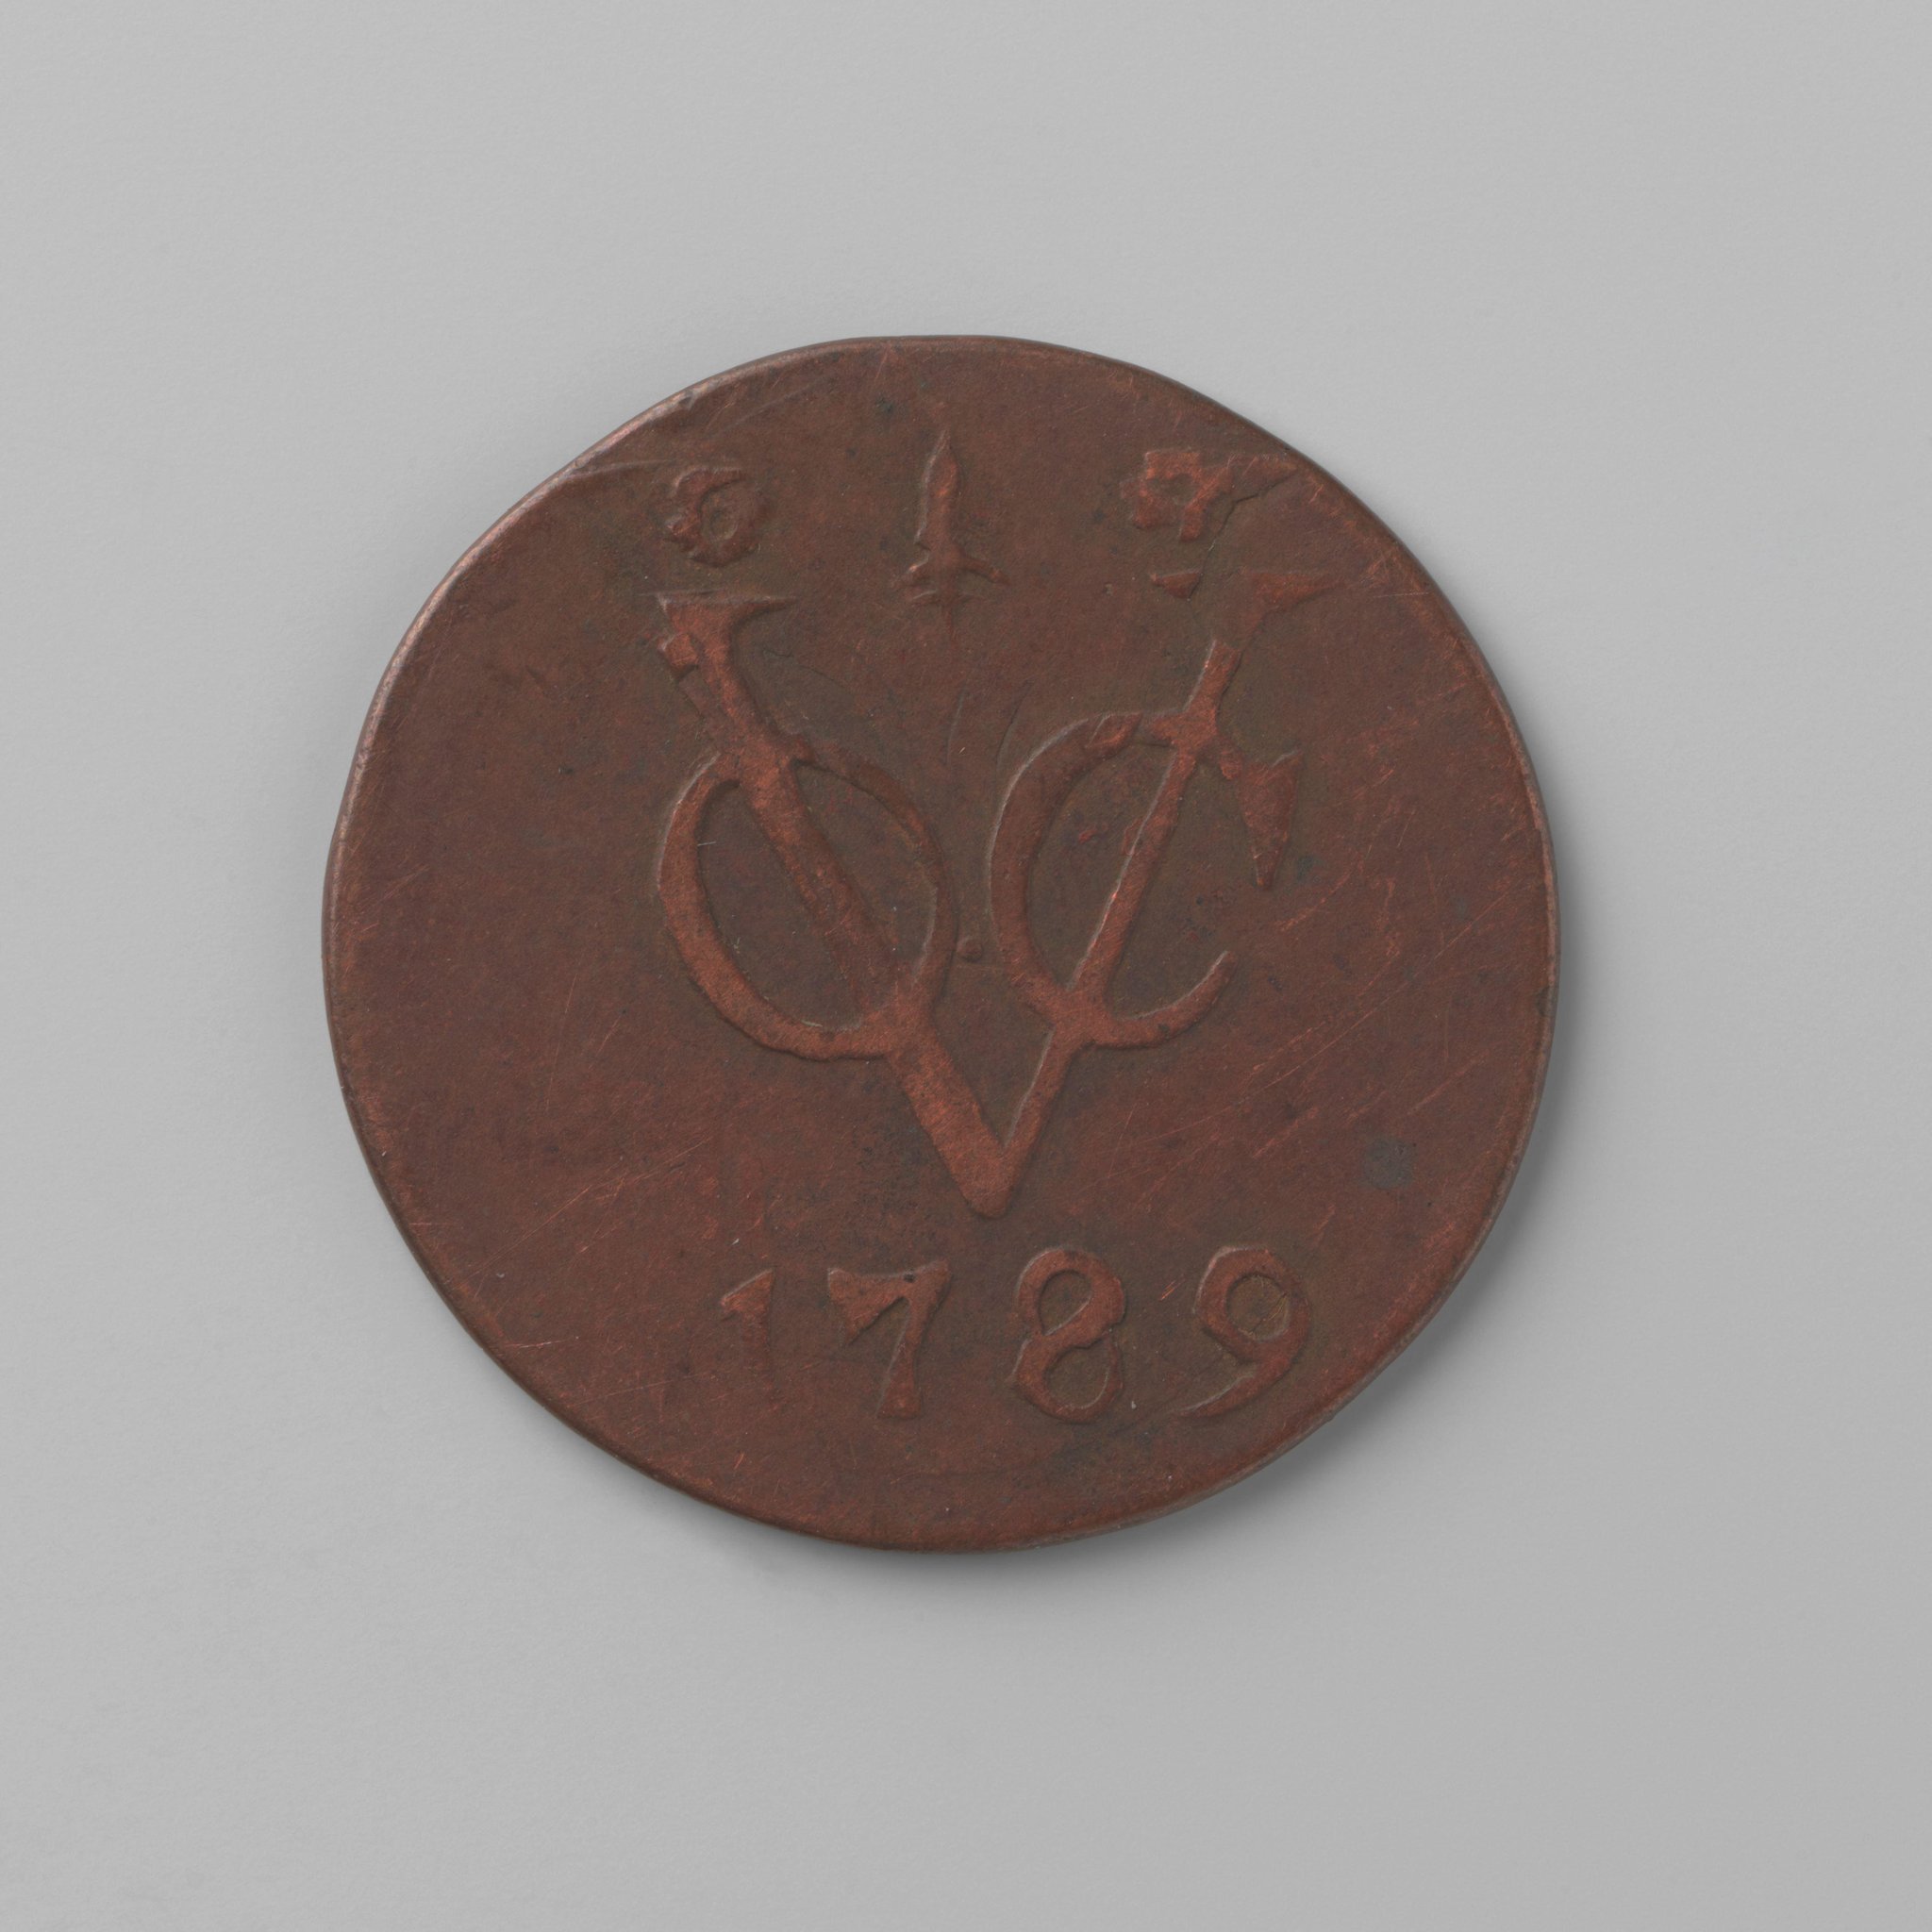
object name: coin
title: VOC, duit Gelderland,1789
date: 1789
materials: copper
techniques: striking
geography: harderwijk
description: Koperen munt. Voorzijde: tussen wapenspreuk gekroond wapenschild van Gelderland. Keerzijde: monogram van de VOC, waarboven muntmeesterteken en waaronder jaartal. Gladde rand.